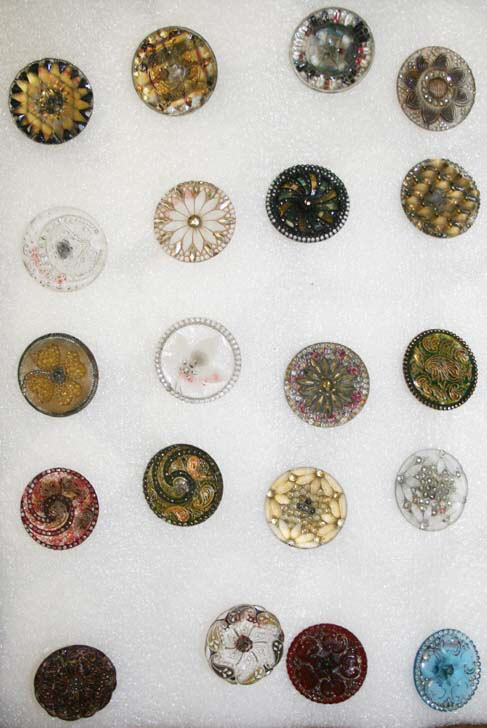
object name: button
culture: american or european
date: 1880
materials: glass